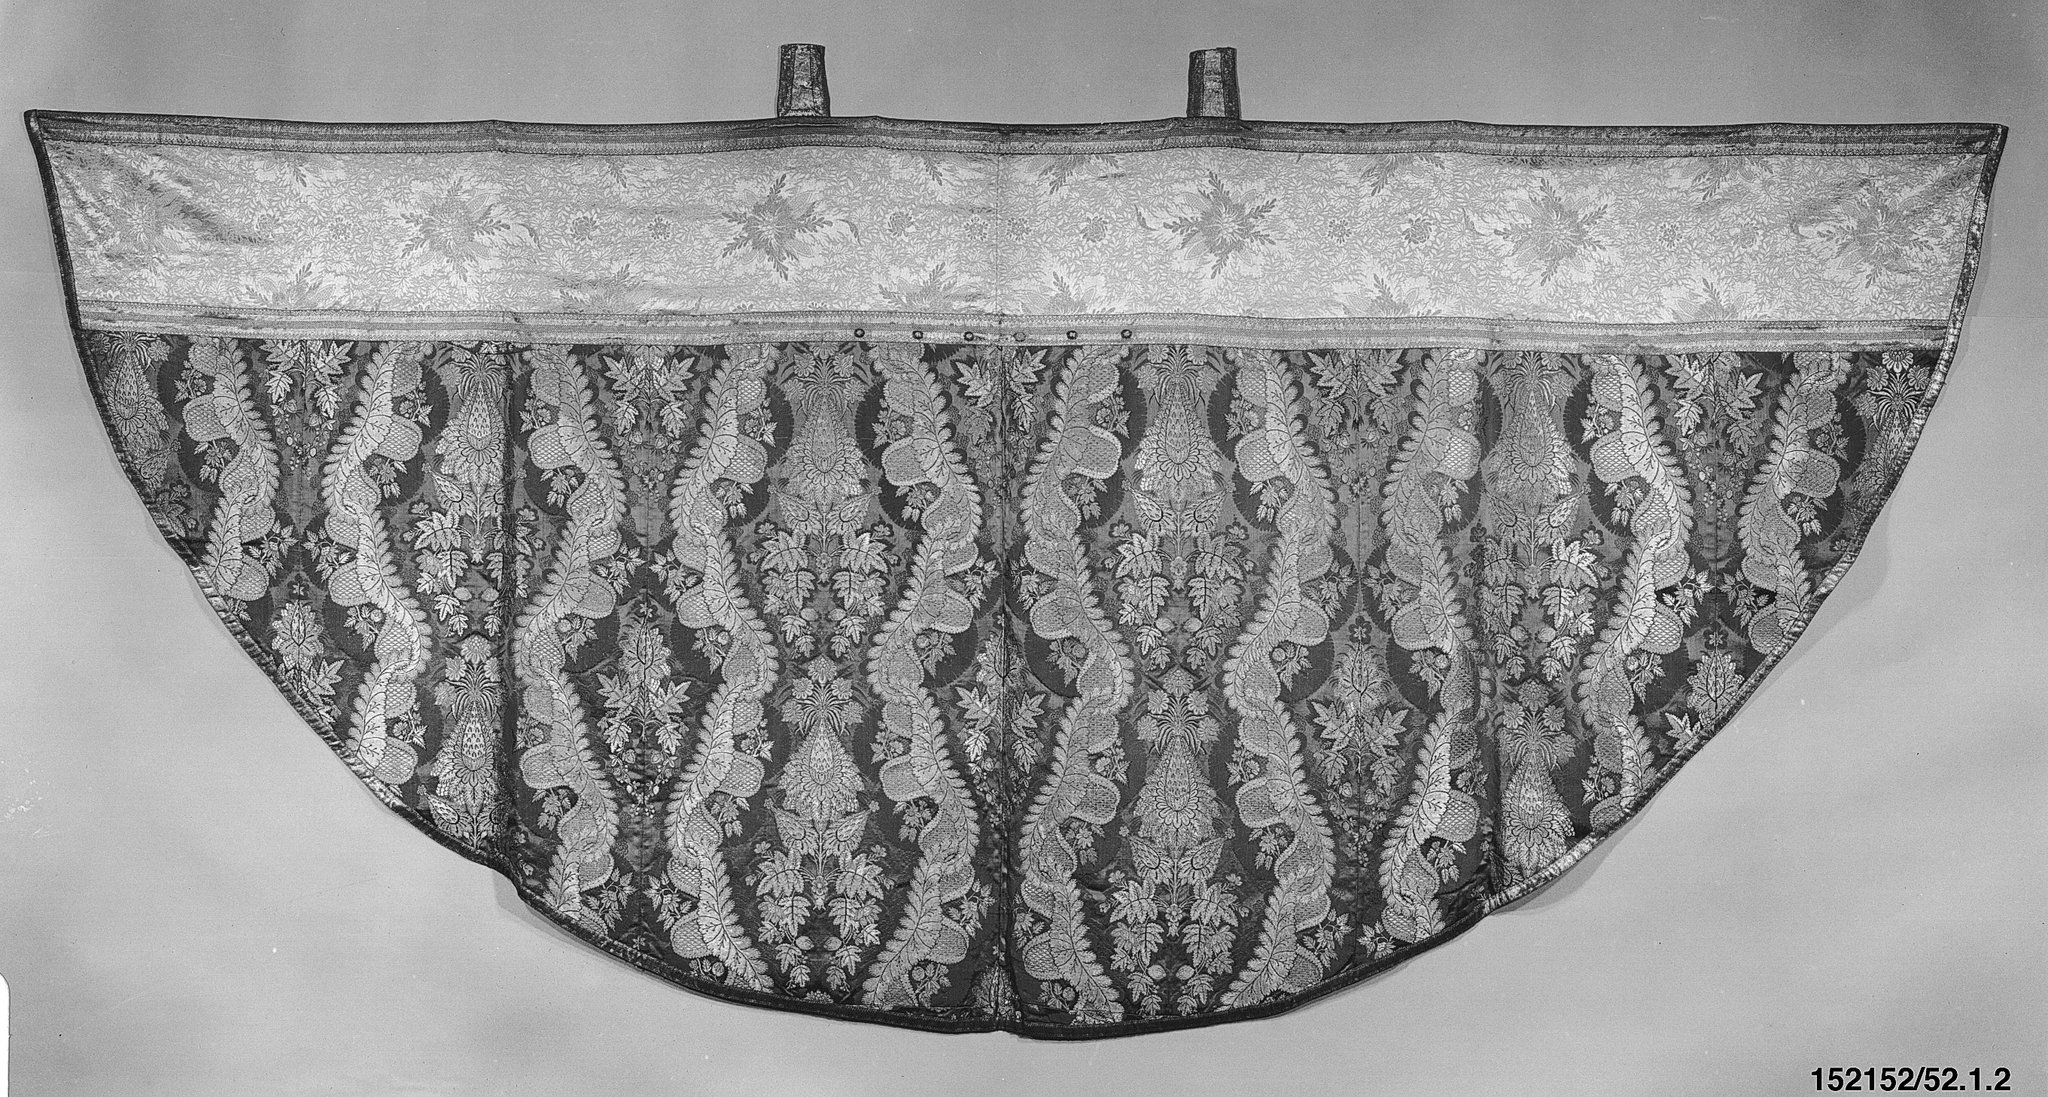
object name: cope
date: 1725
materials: metal thread, silk